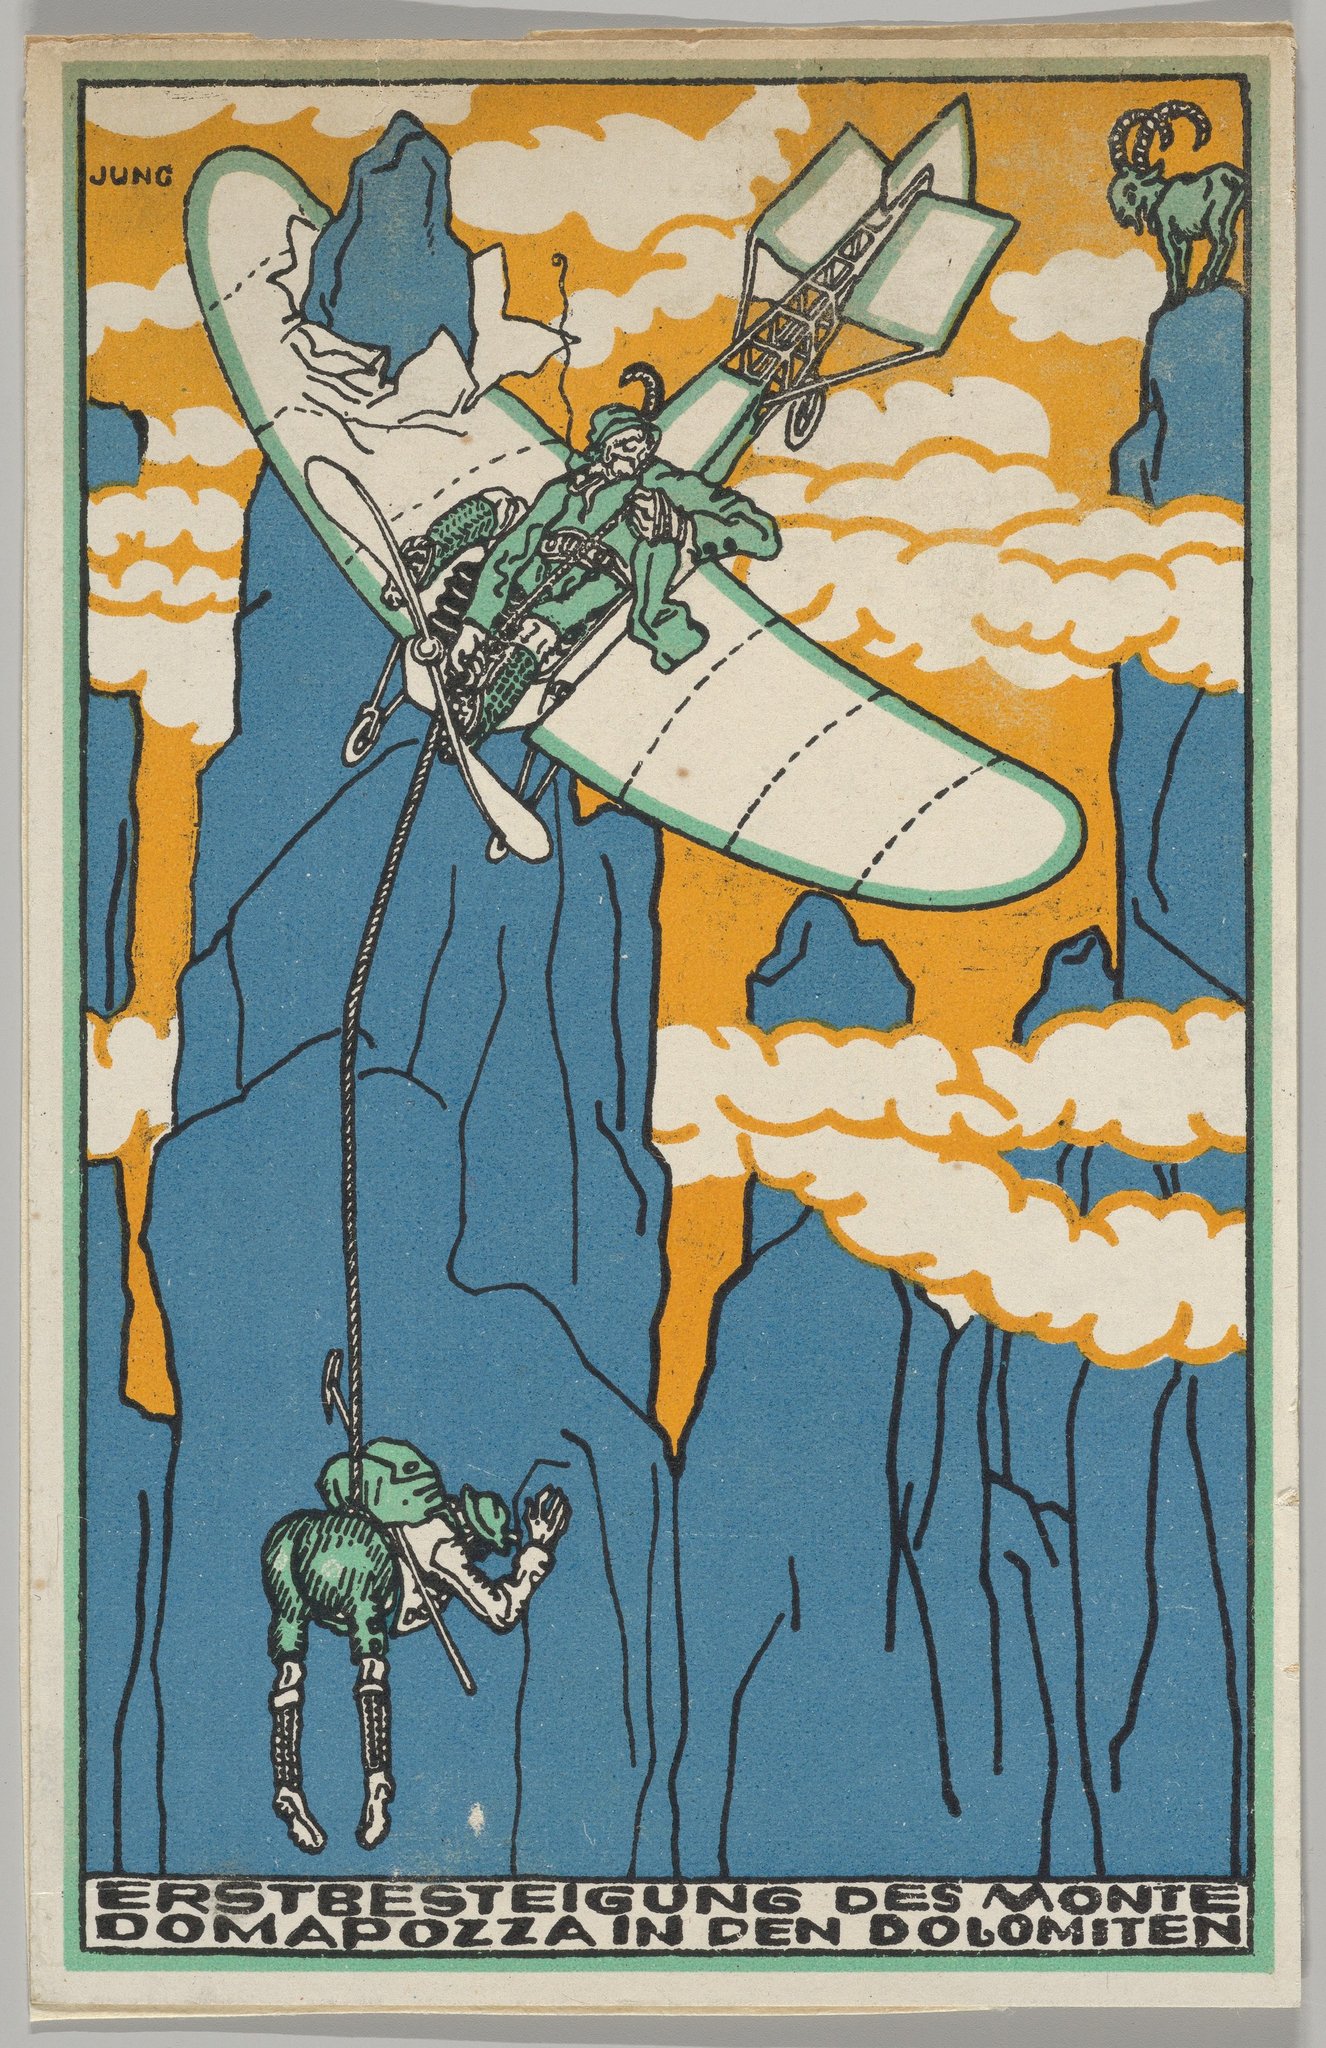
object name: print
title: First Ascent of Monte Domapozza in the Dolomites (Erstbesteigung des Monte Domapozza in den Dolomiten)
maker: moriz jung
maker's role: artist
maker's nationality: austrian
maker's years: 1885-1915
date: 1911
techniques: lithograph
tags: men,planes